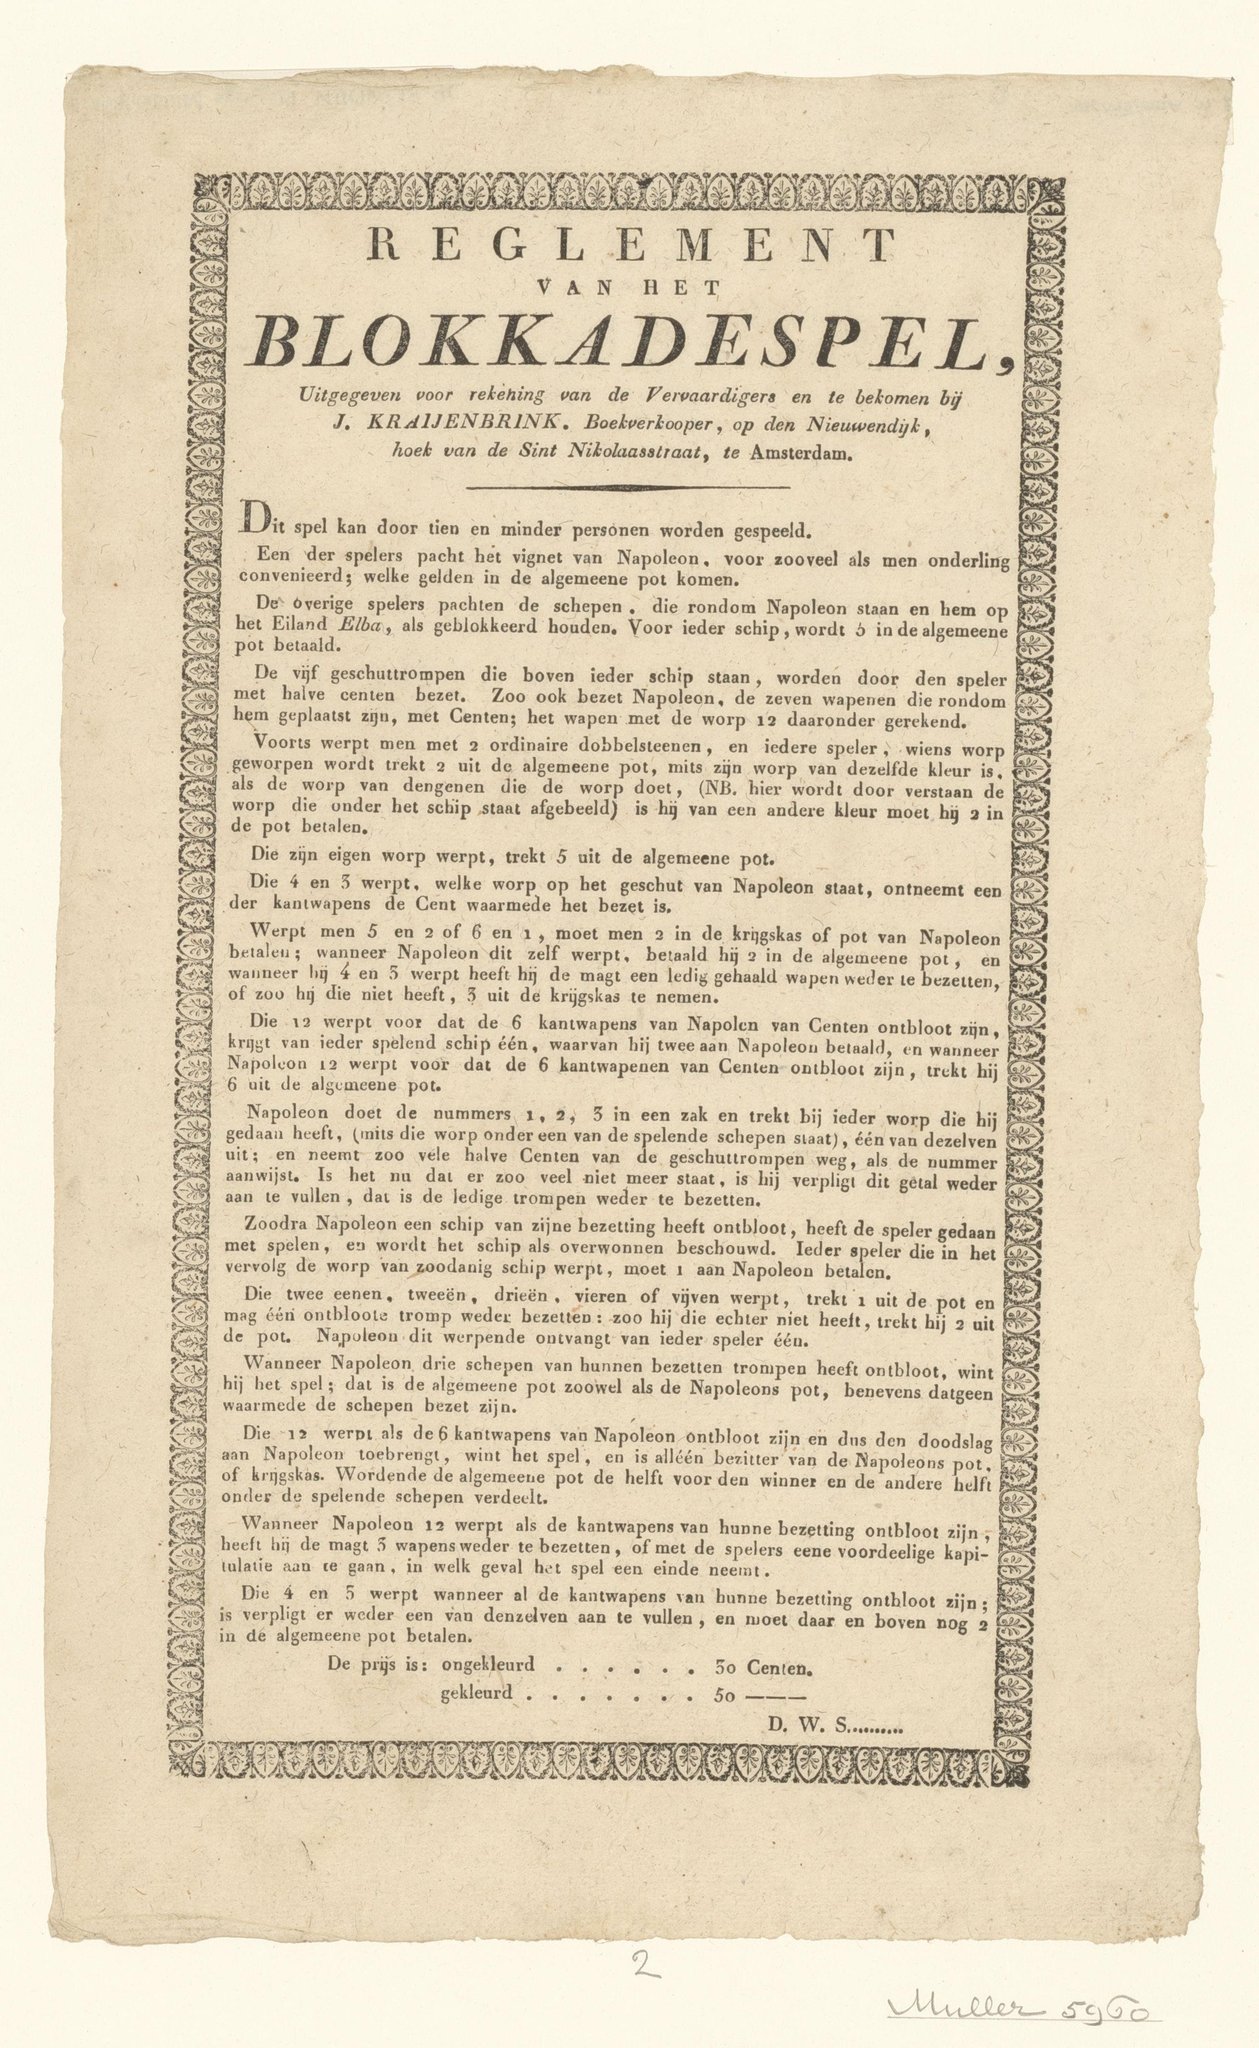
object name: text sheet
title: Reglement van het Blokkadespel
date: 1814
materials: paper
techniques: letterpress printing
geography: amsterdam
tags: napoleon i (emperor of the french), board-games of chance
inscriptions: collector's mark, collector's mark: Lugt 1641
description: Spelregels behorend bij het Blokkadespel Onderwerpsrubrieken binnen de Atlas Zeden en Gewoonten: Spel en Vermaak; gezelschapsspel, ganzenbord en dergelijke.